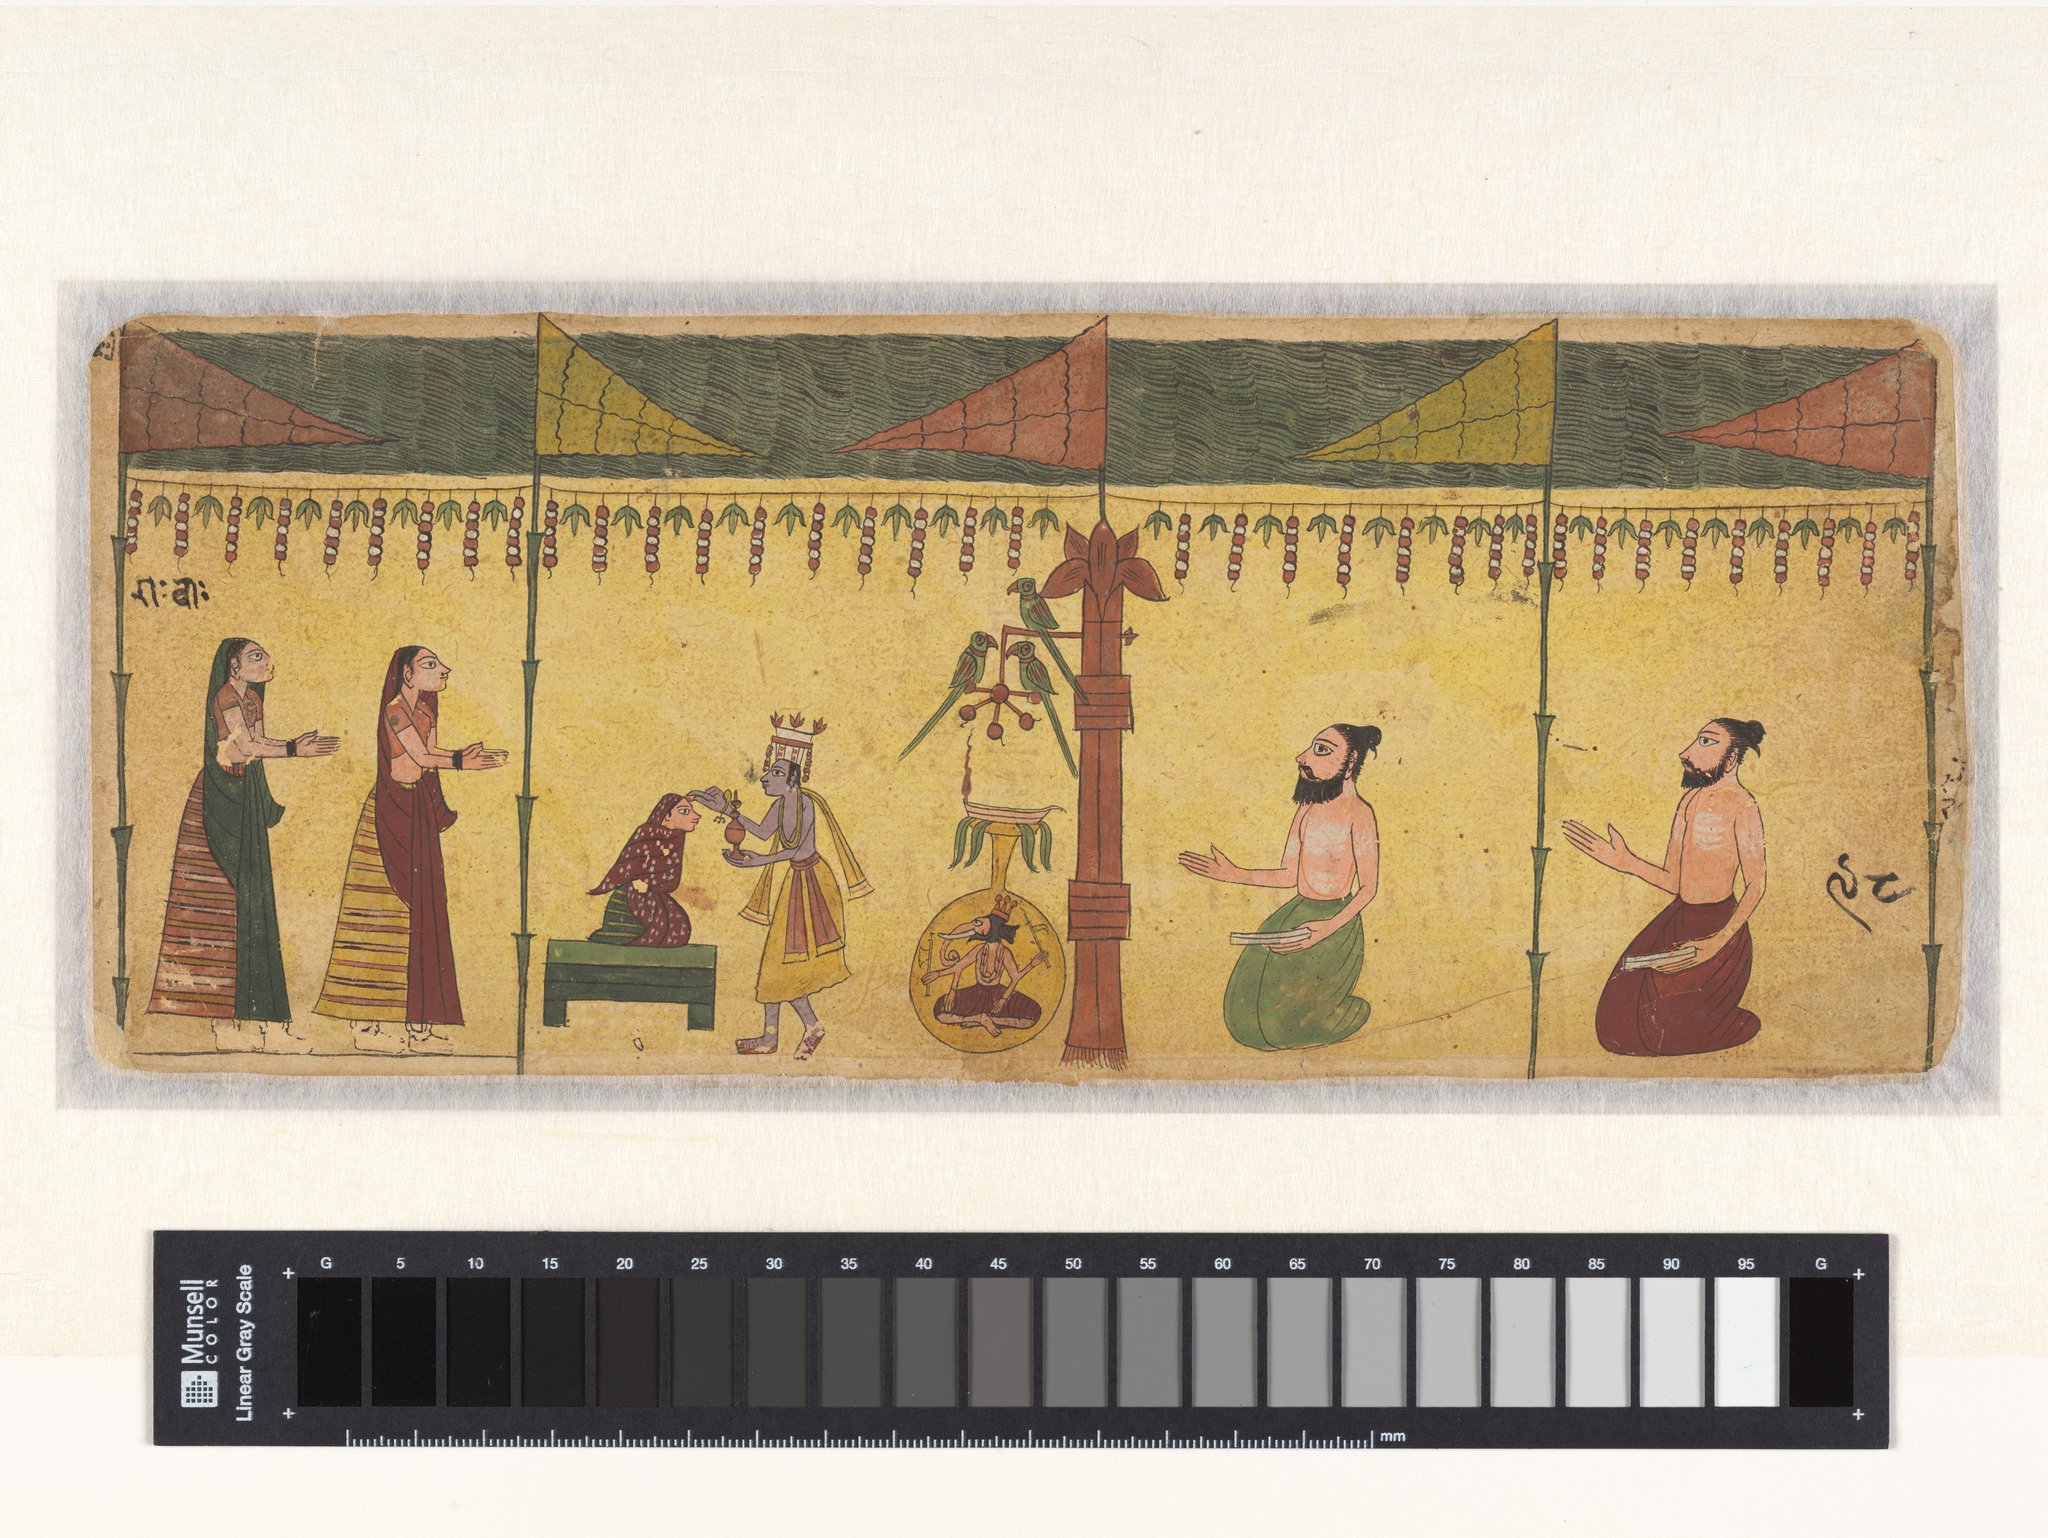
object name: folio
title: Double-sided folio from a Ramayana series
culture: india, himachal pradesh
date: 1690-1710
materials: paper, watercolor